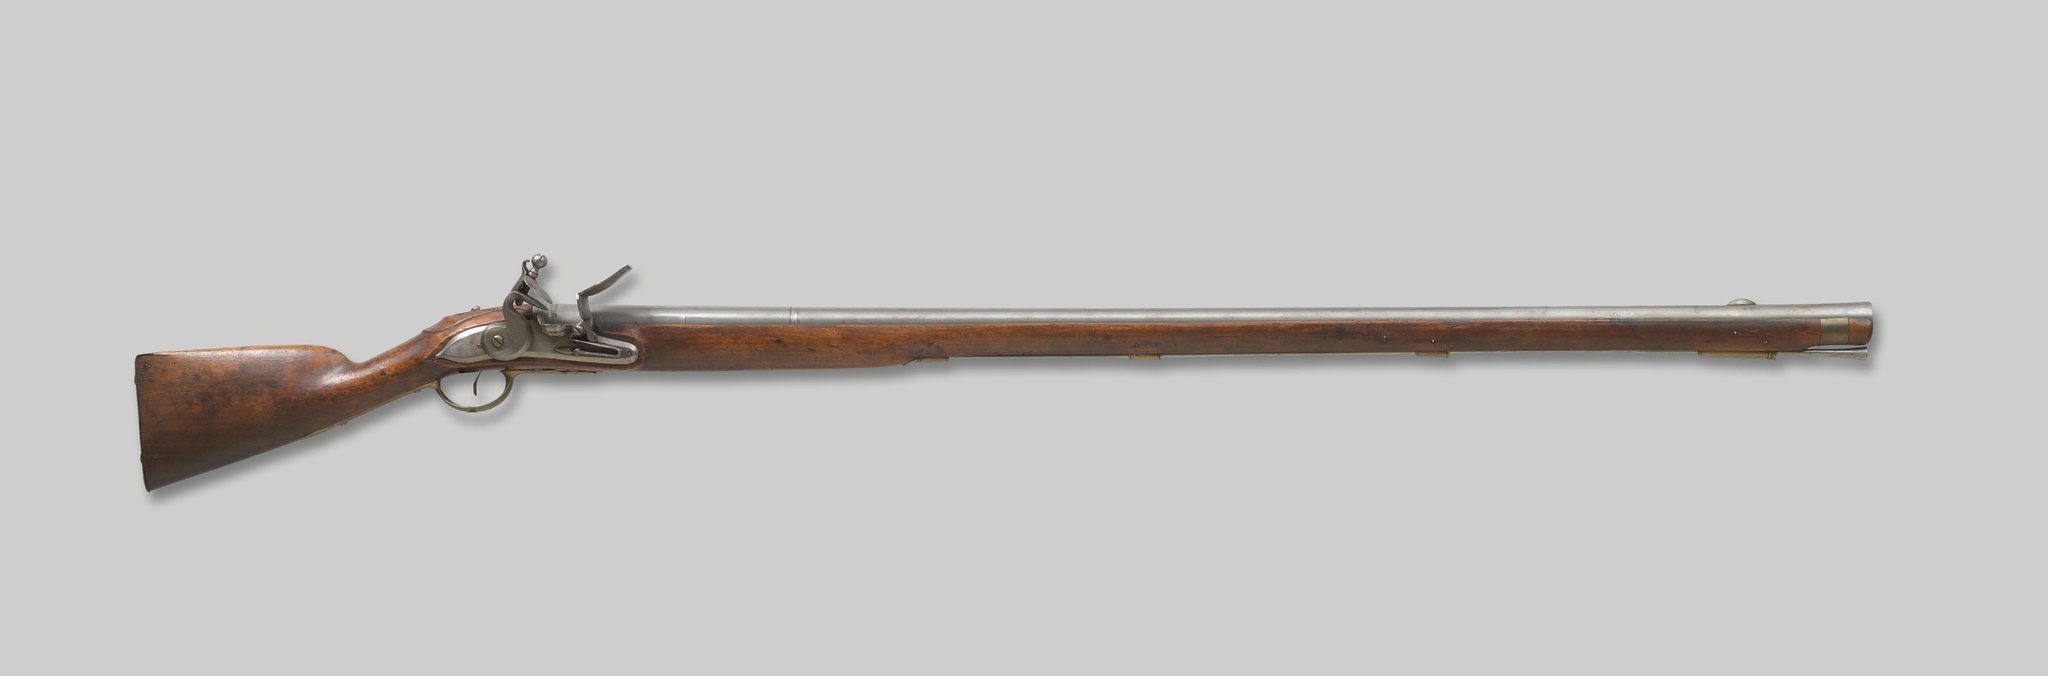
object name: musketoon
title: Flintlock Wall Piece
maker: Anonymous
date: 1825-1840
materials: brass, iron, wood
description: Vestinggeweer of vuursteen walbus, voorlader. De loop wordt niet met beugels aan de lade vastgehouden, maar heeft een klein oog onderop, waar doorheen pennen gestoken worden, die tevens dwars door de lade gaan. Het geweer heeft een ijzeren laadstok.